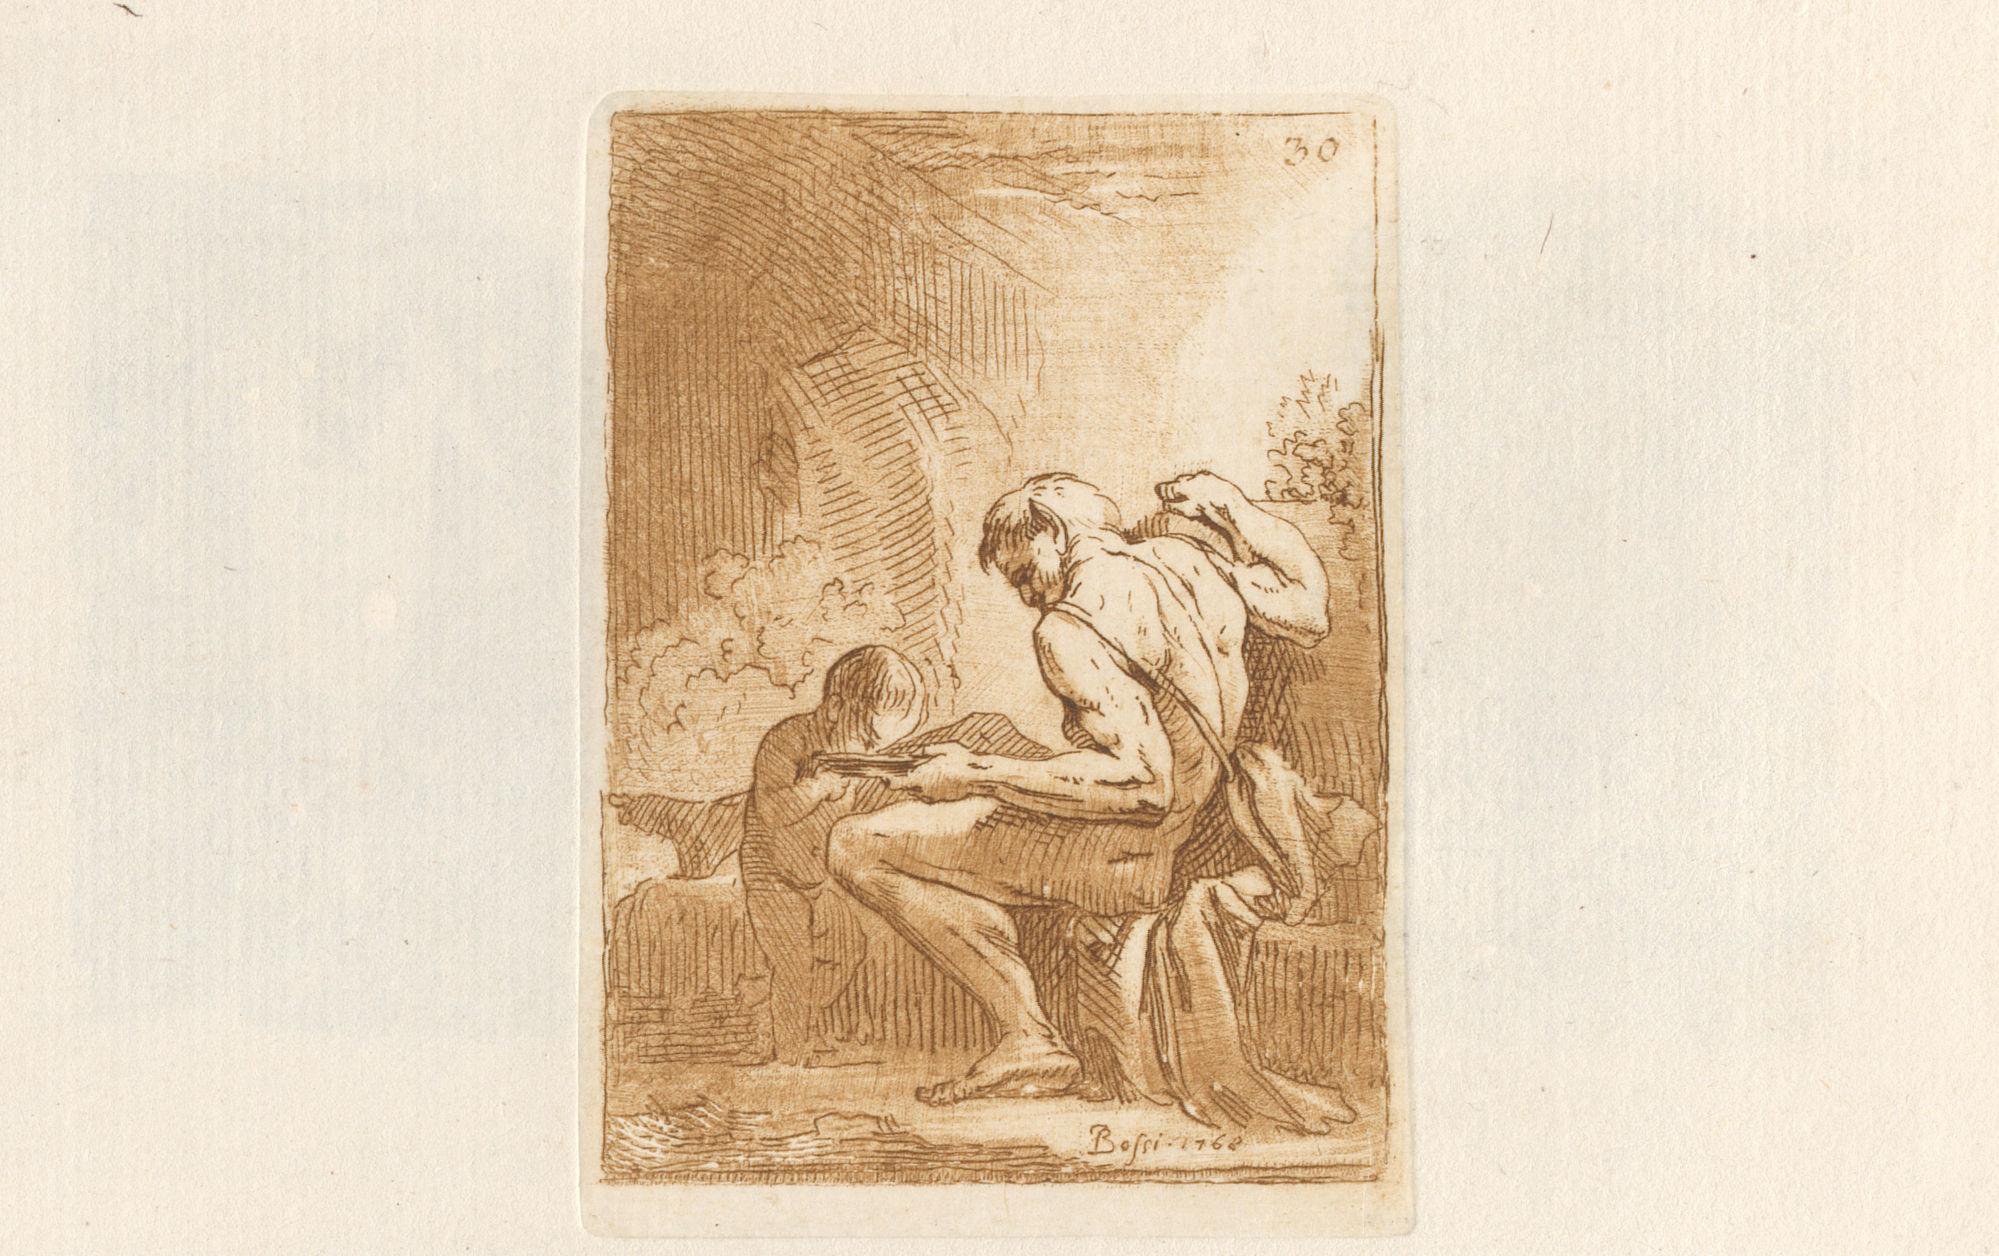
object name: print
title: Raccolta di teste, pensieri, trofei e prove varie d'acquaforte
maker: benigno bossi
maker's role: print maker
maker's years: 1727-1792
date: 1768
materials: paper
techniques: aquatint, etching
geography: parma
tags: (story of) bacchus (dionysus), liber, (story of) silenus